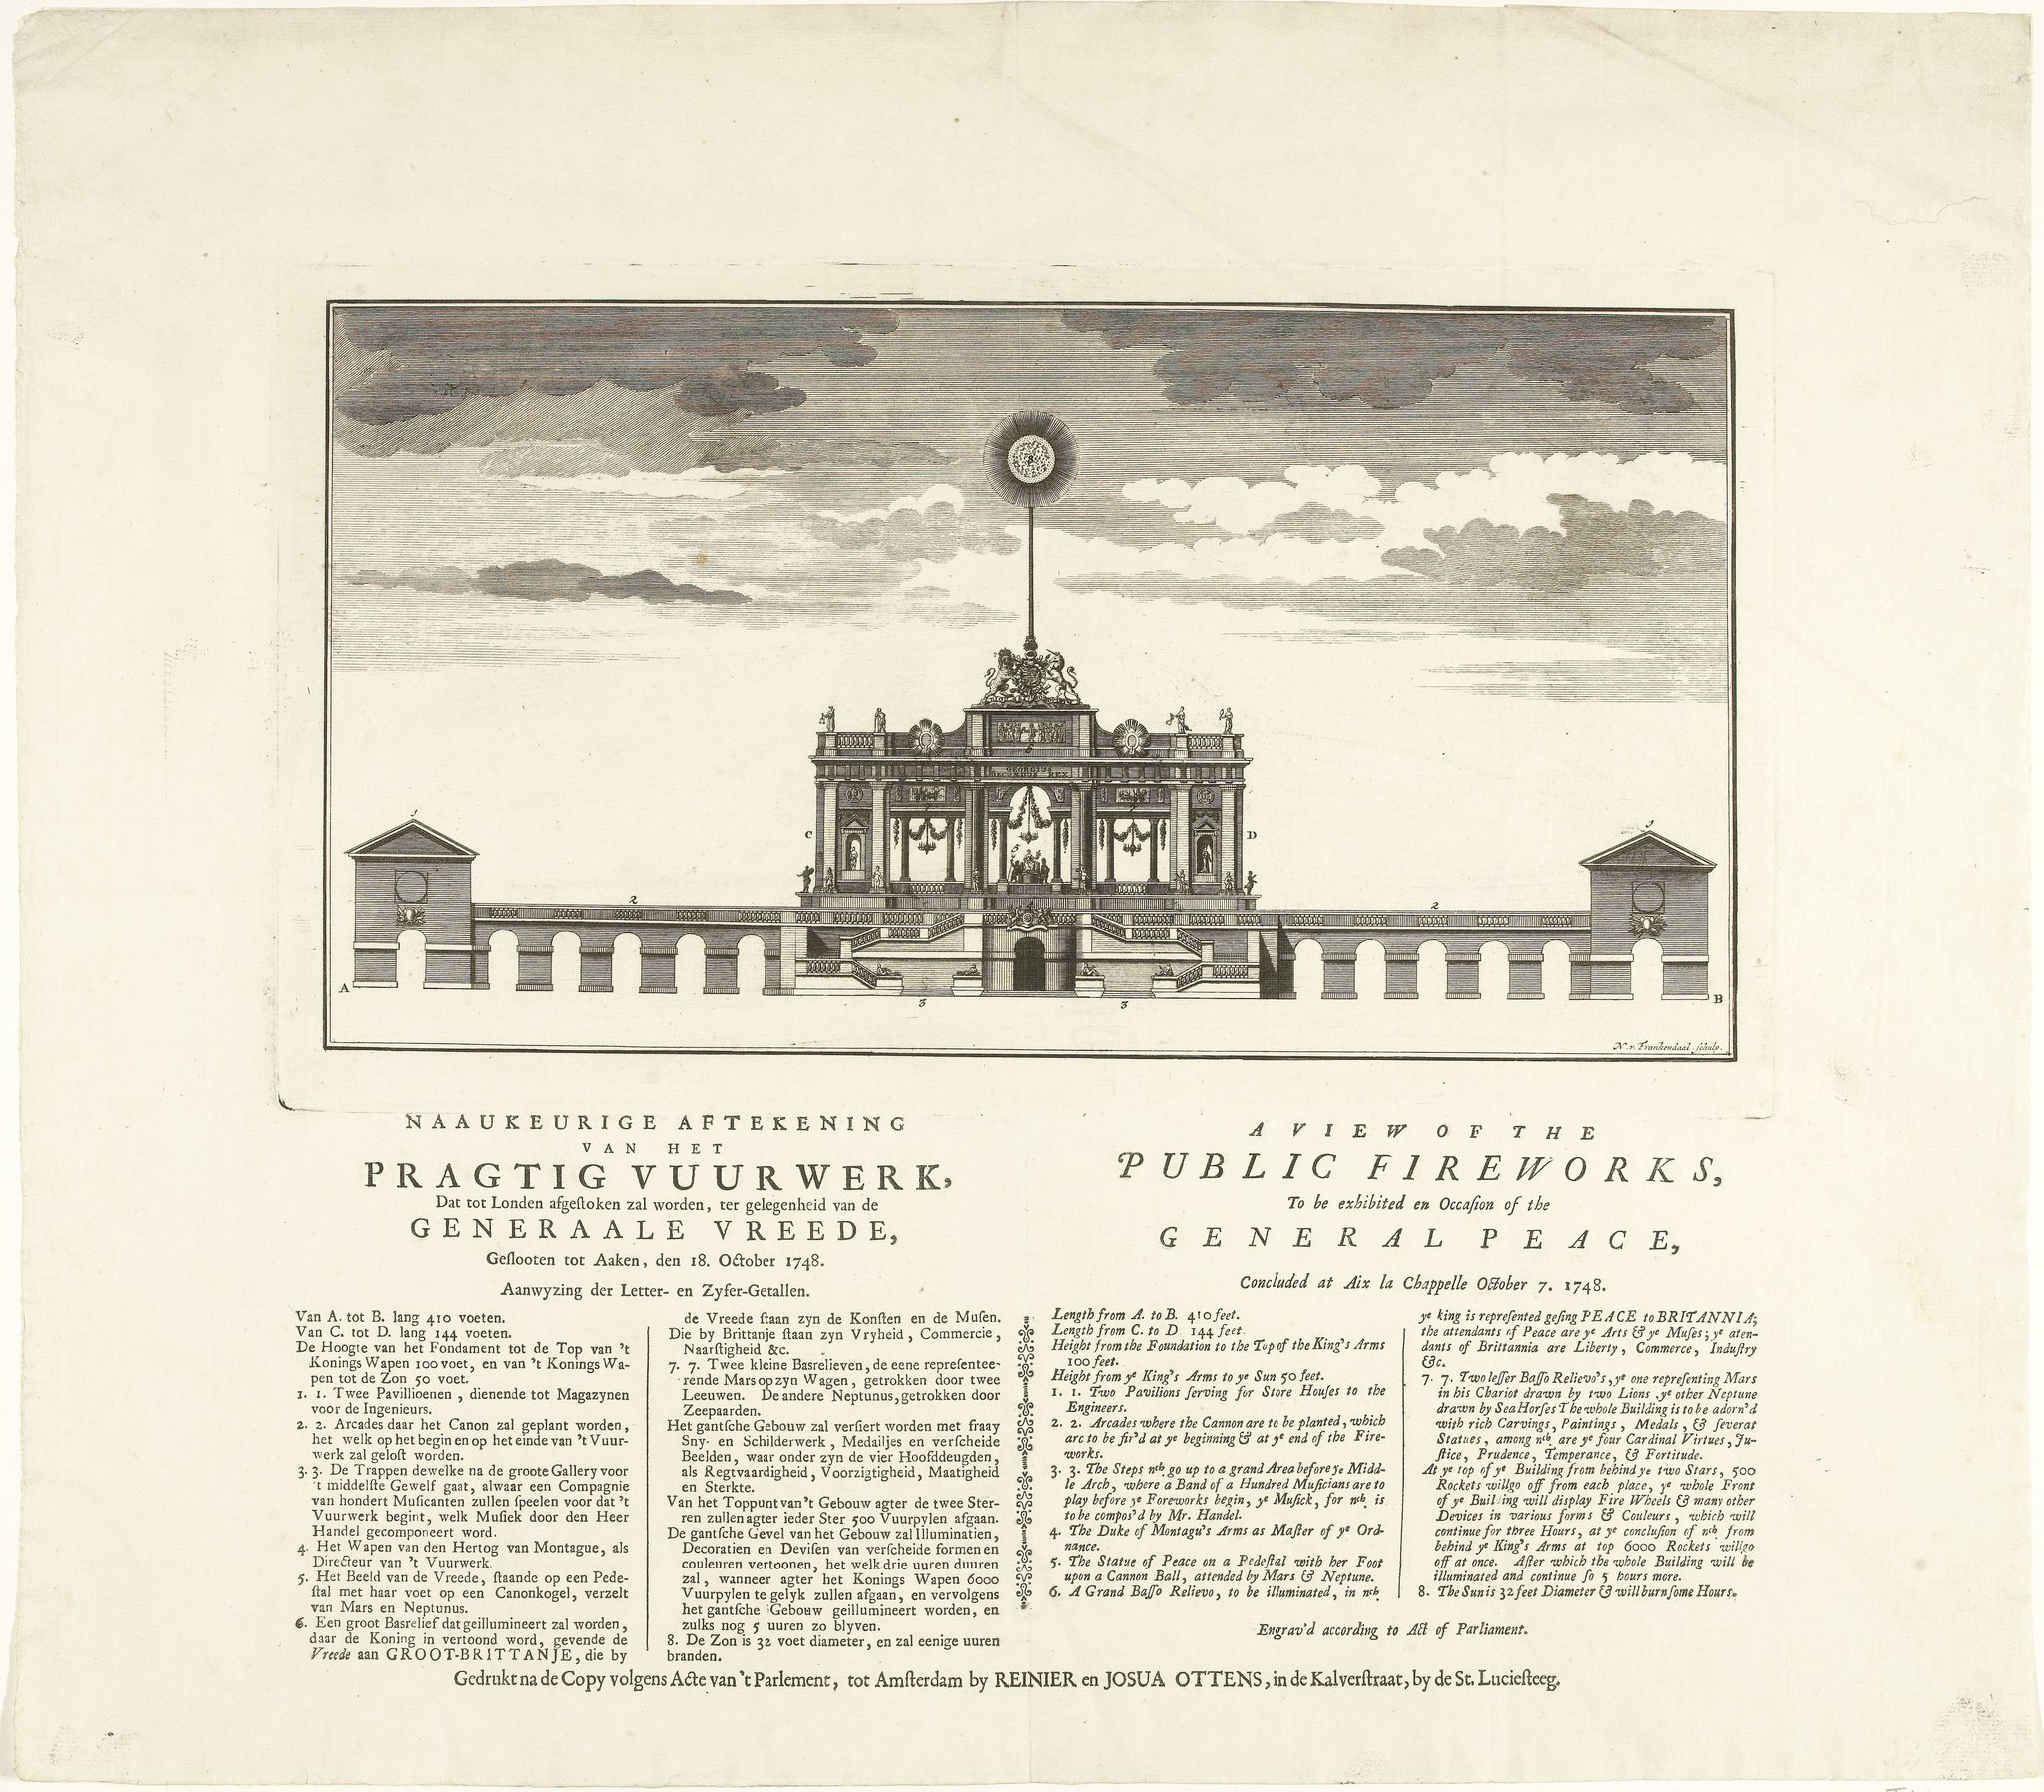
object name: print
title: A View of the Public Fireworks, To be exhibited en Occasion of the General Peace, Concludes at Aix la Chappelle October 7. 1748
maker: nicolaas van frankendaal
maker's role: print maker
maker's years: 1720-1791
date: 1749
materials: paper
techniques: etching, letterpress printing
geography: northern netherlands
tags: bonfire, fire-works (+ illumination, fire-works ~ festive activities), london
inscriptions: collector's mark: Lugt 2228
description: Stellage voor het vuurwerk dat op 27 april 1749 in Green Park te Londen afgestoken zal worden ter gelegenheid van de Vrede van Aken, gesloten op 18 oktober 1748. Dit is gebeurtenis waarvoor G.F. Händel de Music for the Royal Fireworks schreef. Aanzicht van het bouwwerk, op het blad onder de plaat de titels en verklaringen in het Nederlands en Engels.